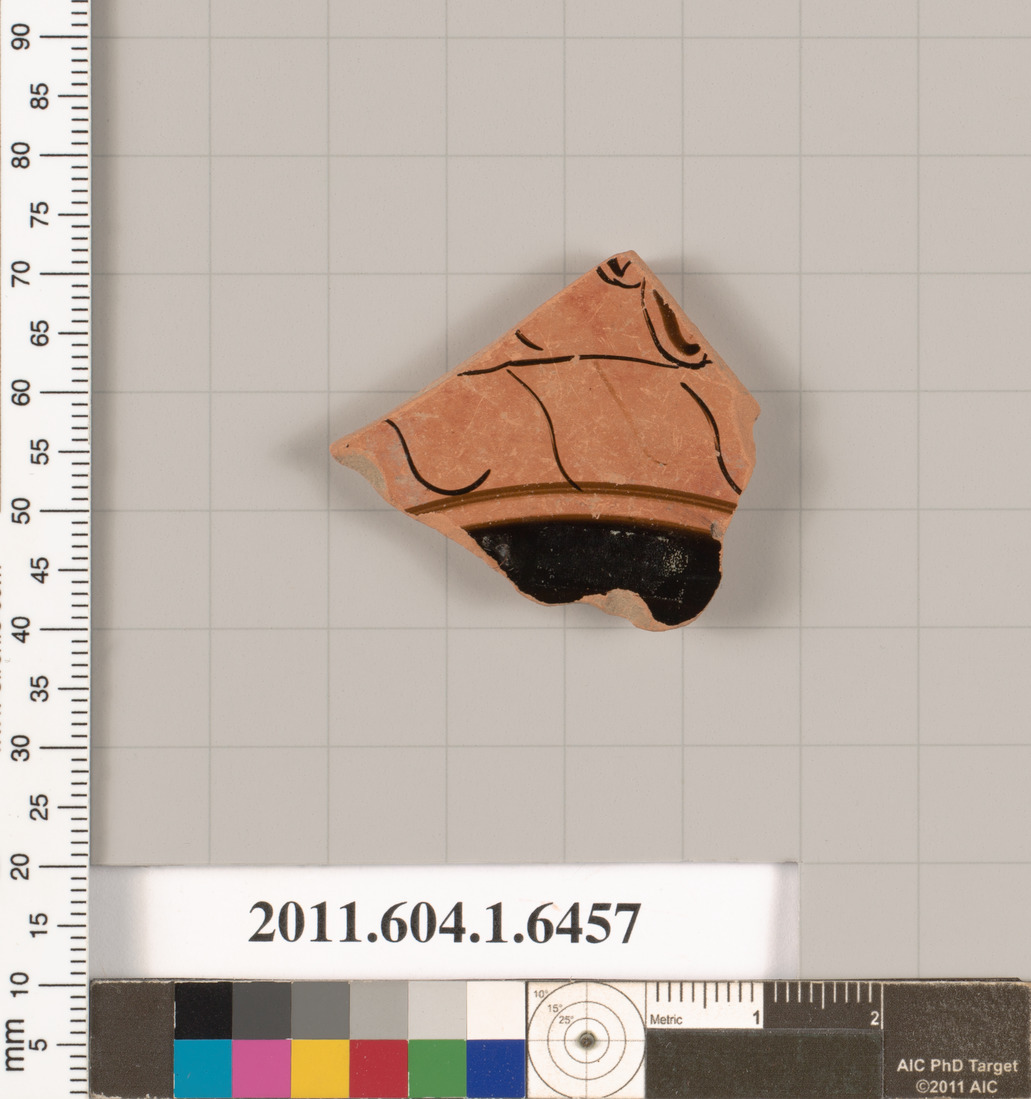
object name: kylix fragment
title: Terracotta fragment of a kylix (drinking cup)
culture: greek, attic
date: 490-480 BCE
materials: terracotta